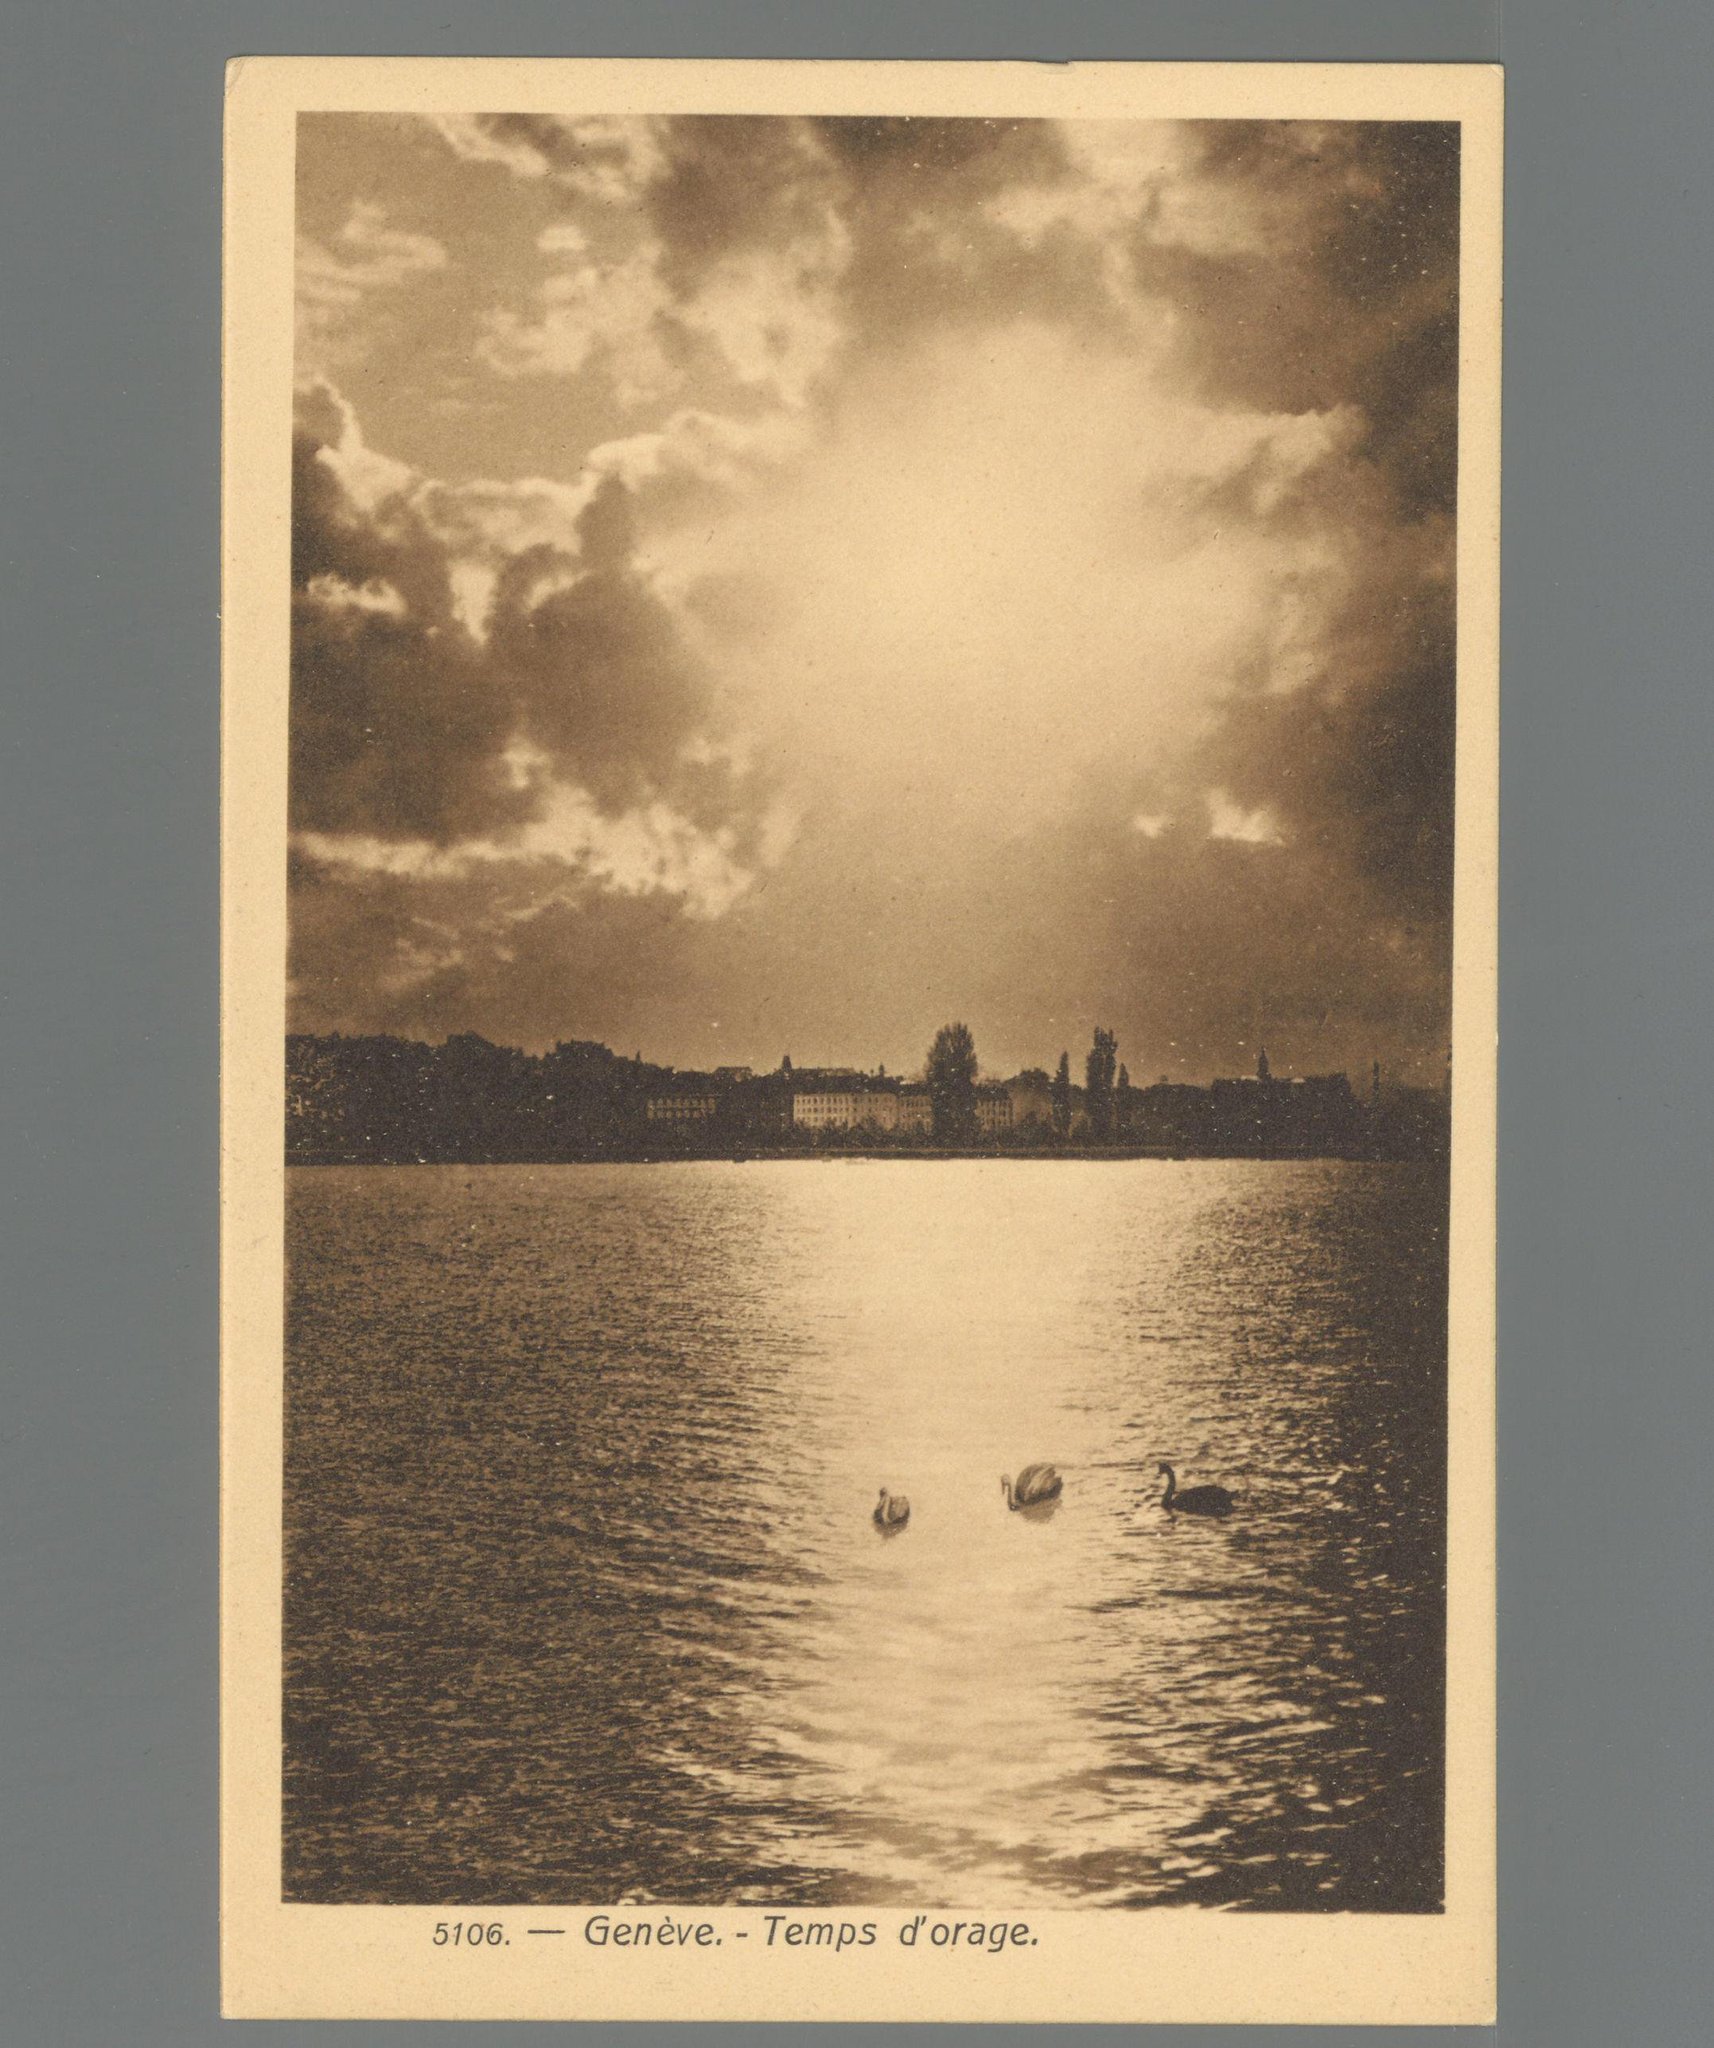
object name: photomechanical print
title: Genève. Temps d'orage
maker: Anonymous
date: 1905-1909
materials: cardboard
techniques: photograph, writing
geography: geneva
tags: lake, thunderstorm, prospect of city, town panorama, silhouette of city